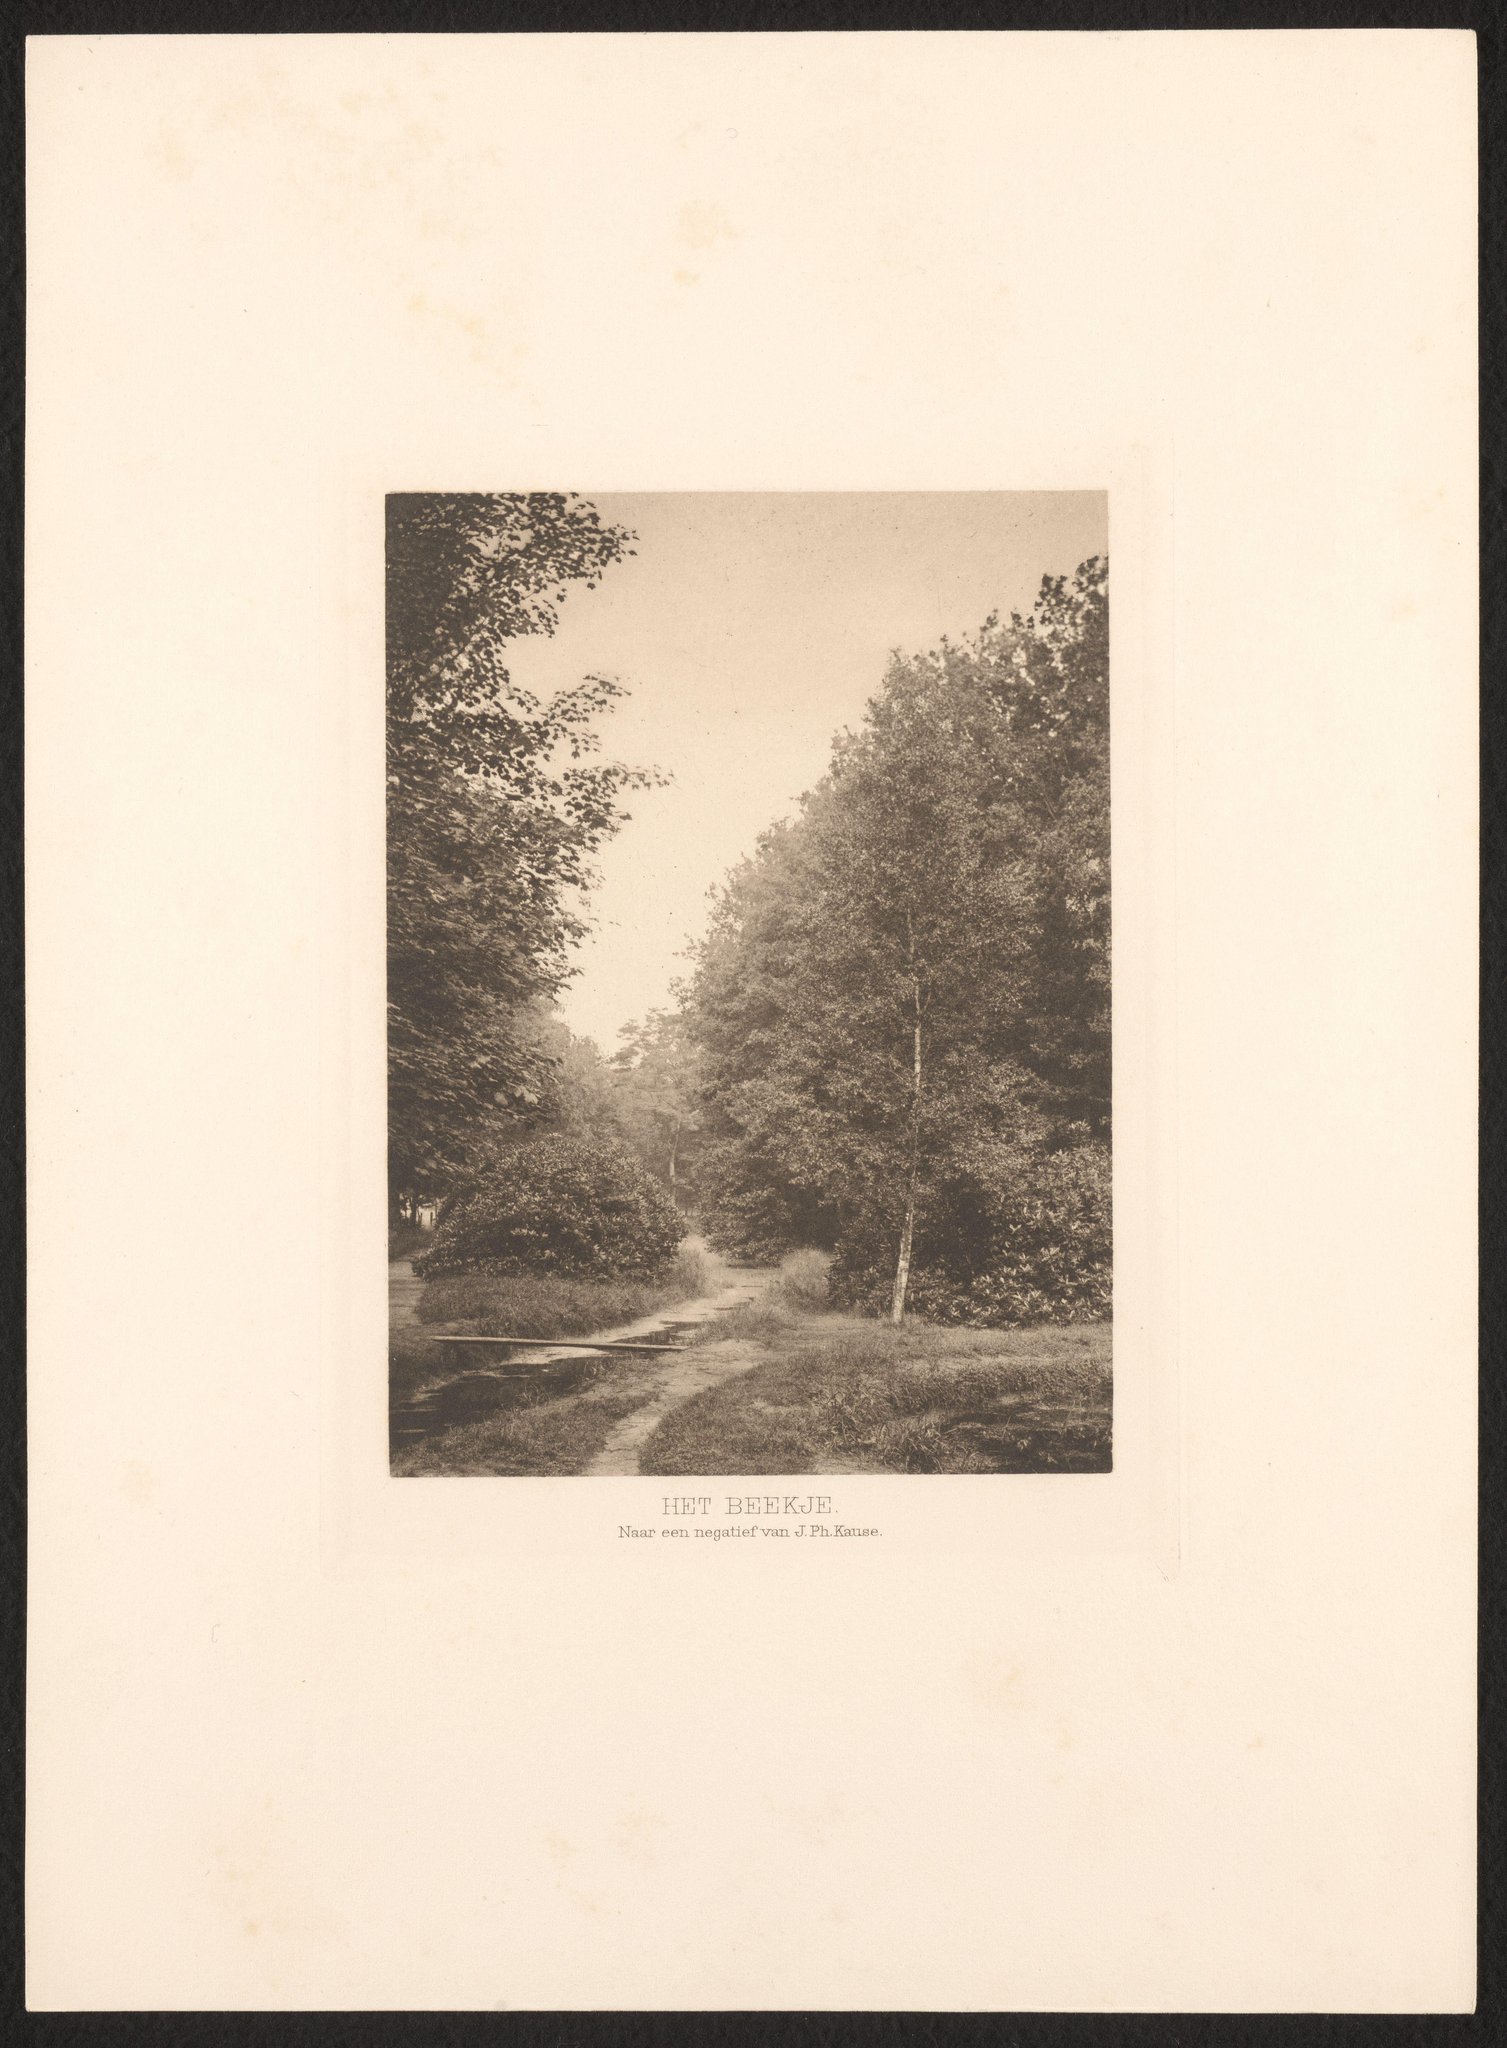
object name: page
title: Beek in een bos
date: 1900-1905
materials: paper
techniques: photoaquatint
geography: netherlands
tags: forest, wood, brook